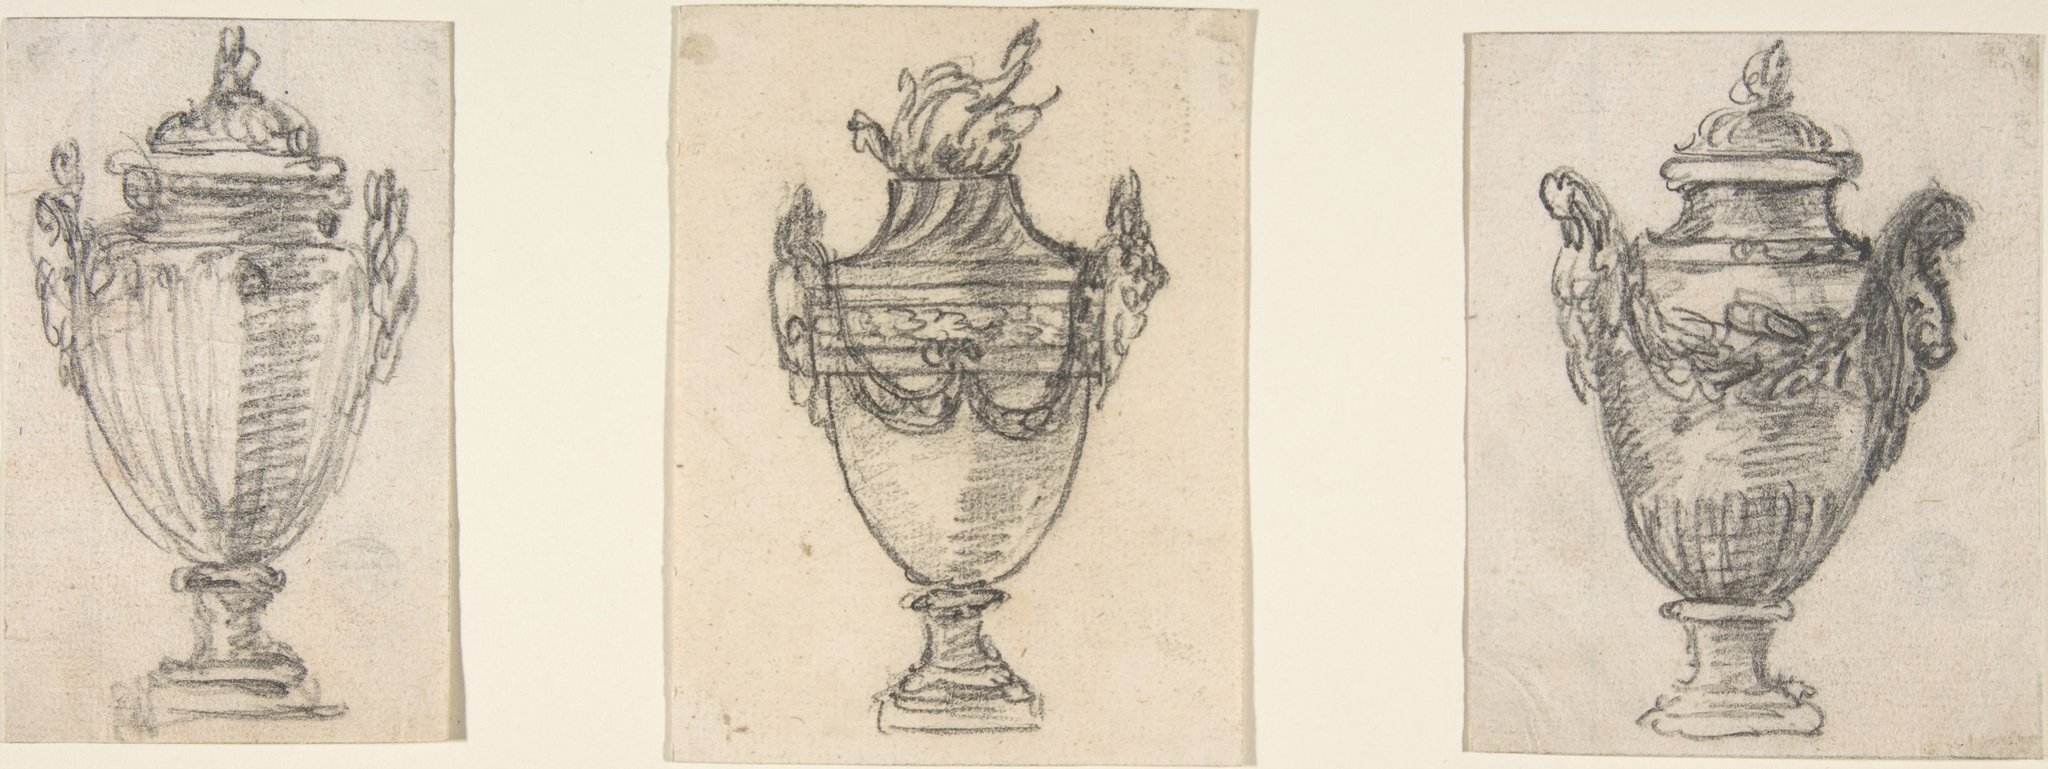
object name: drawing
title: Three Designs for Covered Vases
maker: anonymous, french, 18th century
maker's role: artist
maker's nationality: french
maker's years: 1700-1800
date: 1701-1800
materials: graphite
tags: vases